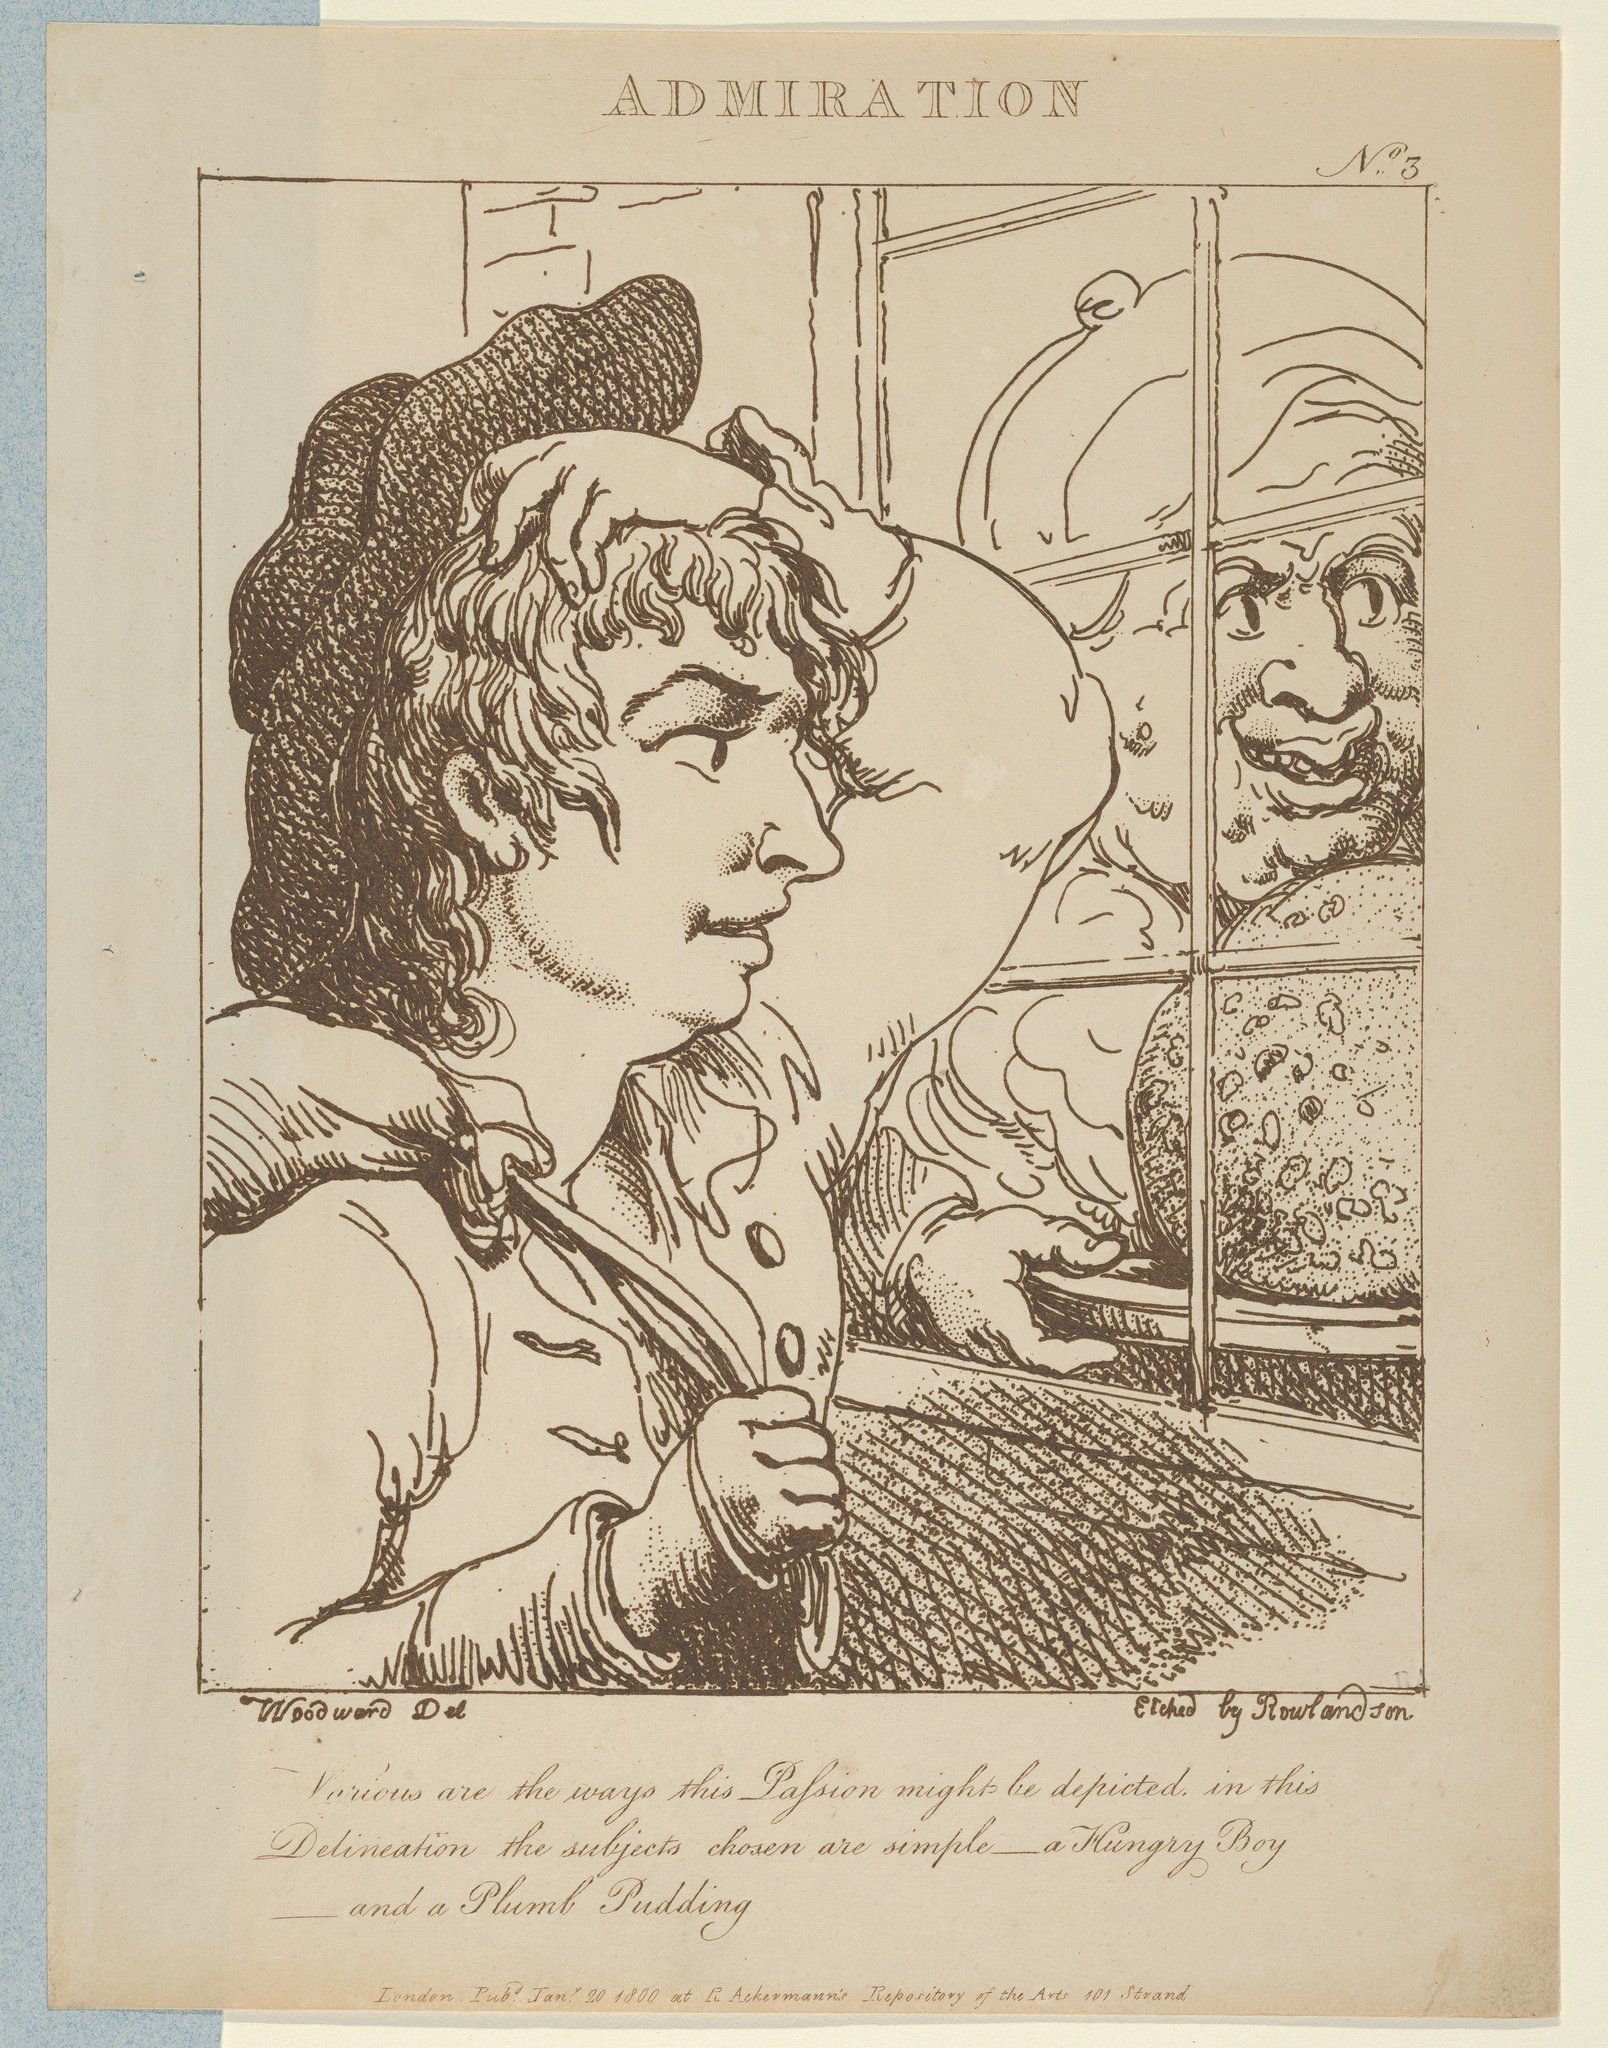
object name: print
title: Admiration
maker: thomas rowlandson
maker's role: artist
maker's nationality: british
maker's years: 1757-1827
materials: ink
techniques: etching, printing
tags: men,women